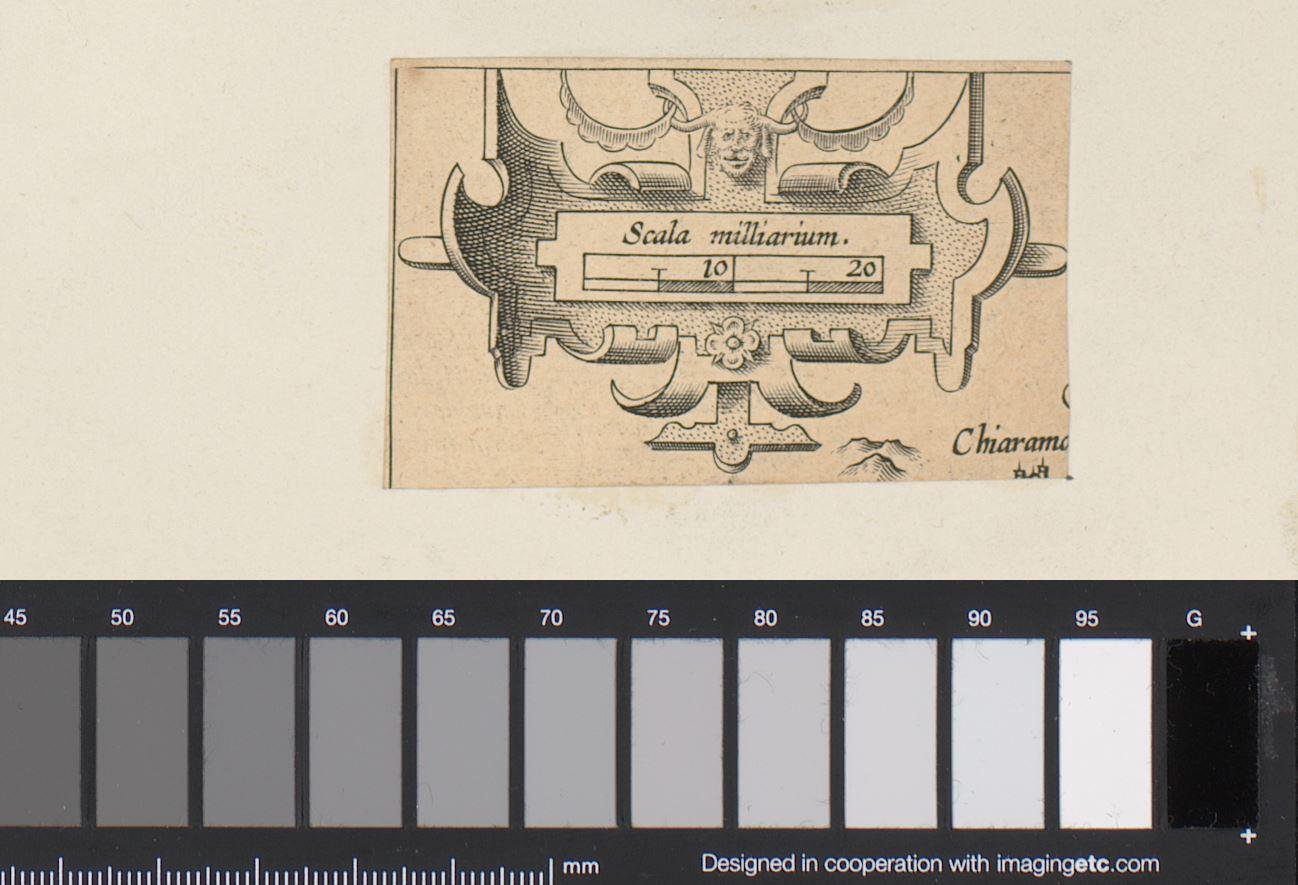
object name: ornament print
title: Theatrum Orbis Terrarum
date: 1590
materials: paper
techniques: engraving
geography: antwerp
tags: birds, ornament ~ cartouche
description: Ronde cartouche met bovenaan een citaat uit Horatius' Odes (Vis consili expers mole ruit sua) en twee roofvogels. De cartouche is een fragment van een kaart van Pannonië en Illyricum. De prent maakt deel uit van een album.